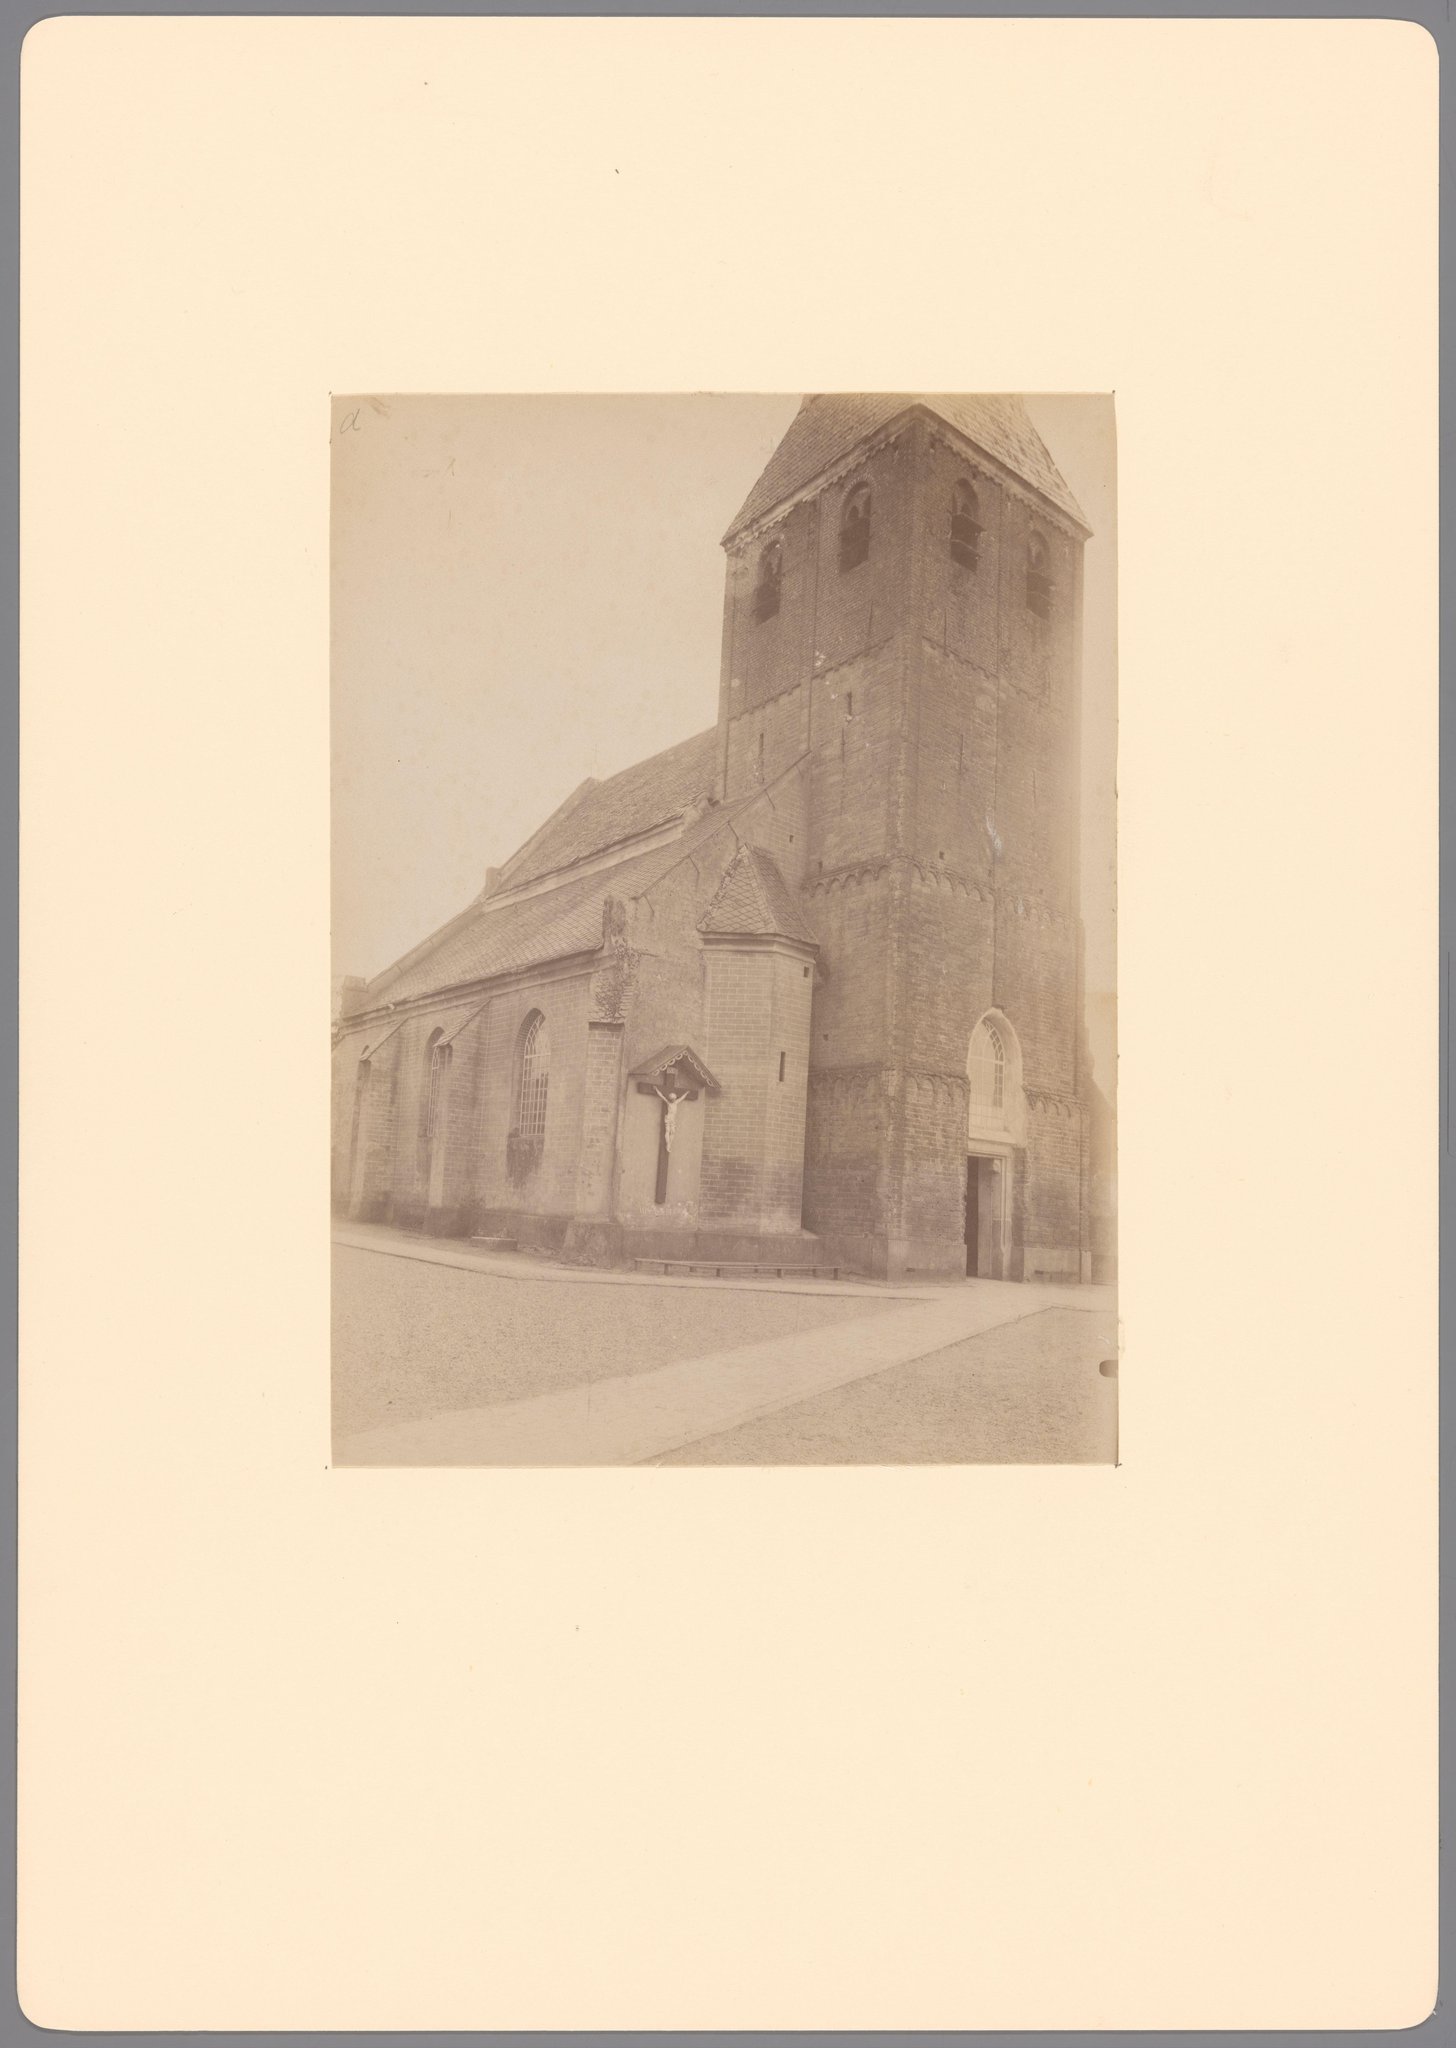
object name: photograph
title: Gezicht op de Remigiuskerk te Duiven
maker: anoniem (monumentenzorg)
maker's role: fotograaf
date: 1905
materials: cardboard, photographic support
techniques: albumen print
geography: duiven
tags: church (exterior)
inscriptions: annotation: ‘Duiven/ R.K. Kerk’, annotation: ‘d’